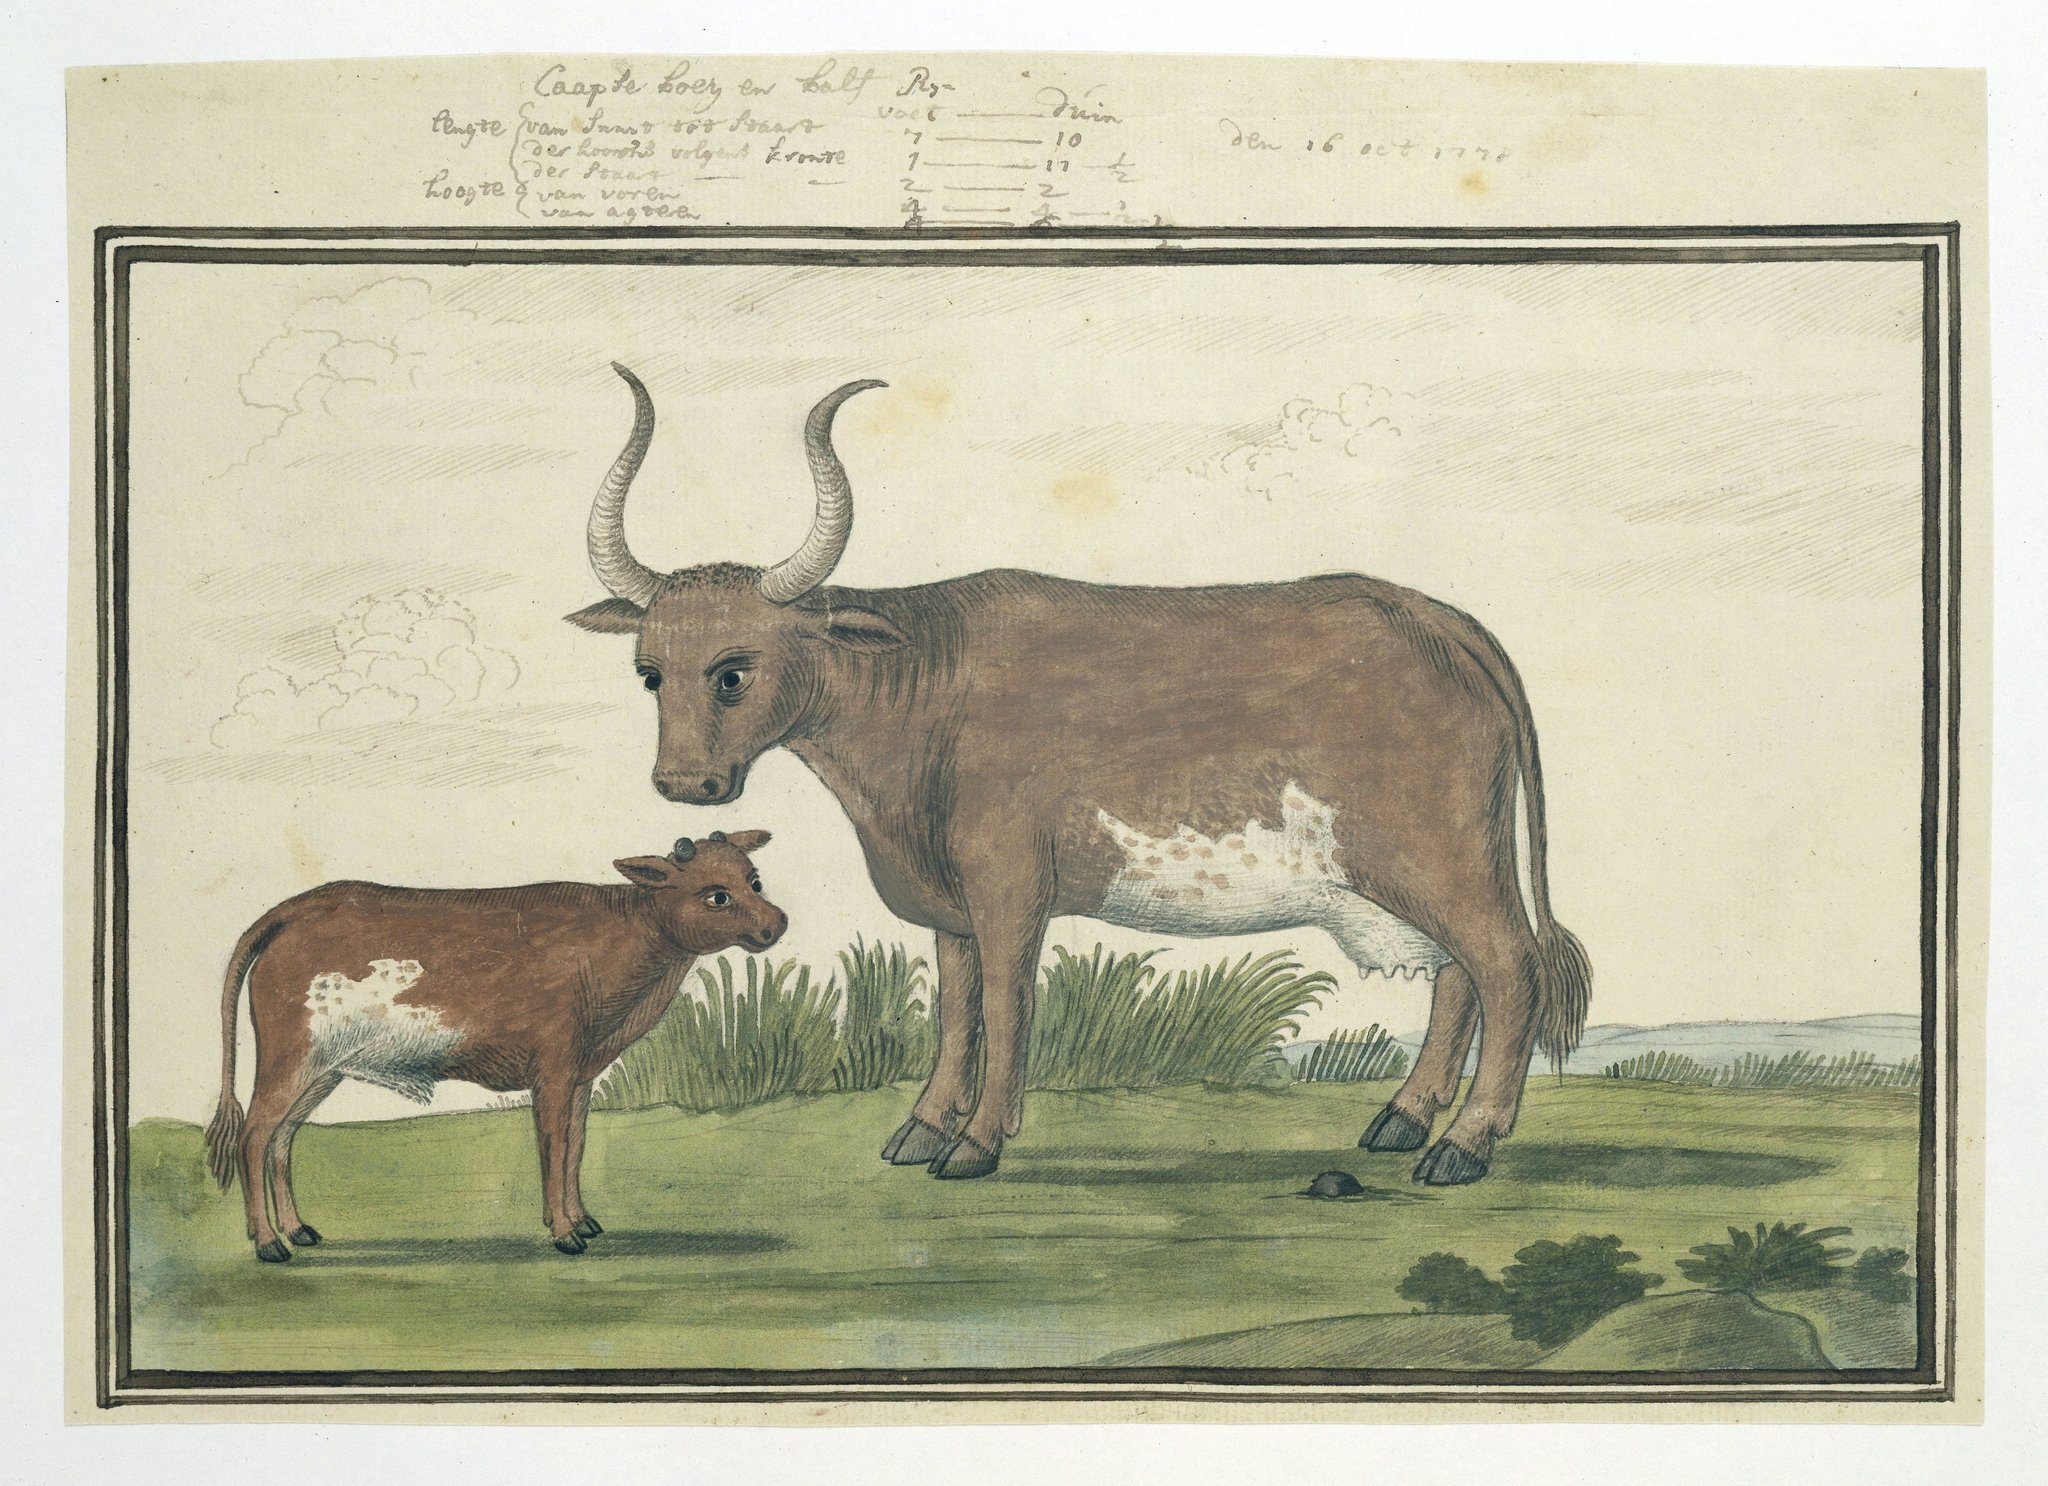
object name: album leaf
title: Bos taurus: Cape cow and calf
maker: robert jacob gordon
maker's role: draughtsman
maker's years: 1743-1795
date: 1778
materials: paint, ink, paper, pencil, watercolor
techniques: brush, pen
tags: cow, animals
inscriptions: date: ‘[...] den 16 oct 1778.’, date: ‘[...] den 16 oct 1778.’, annotation: ‘Caapse koey en kalf/[...]’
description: Kaapse koe en haar kalf. In deze periode verbleef Gordon op de boerderij van Willem Prinsloo, het huidige Somerset East in de Sneeuwbergen.